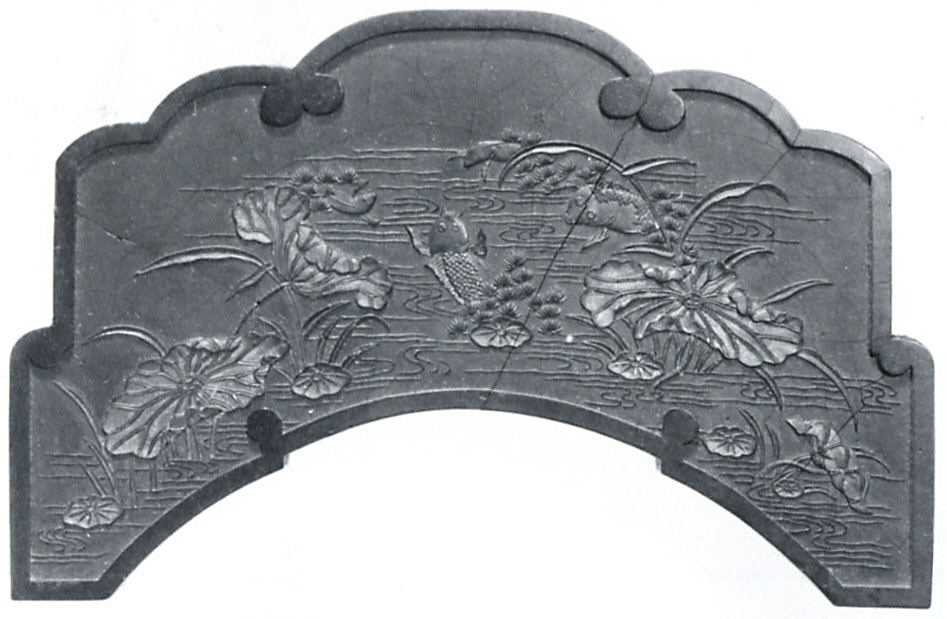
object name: ink tablet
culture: chinese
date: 1867-1933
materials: ink